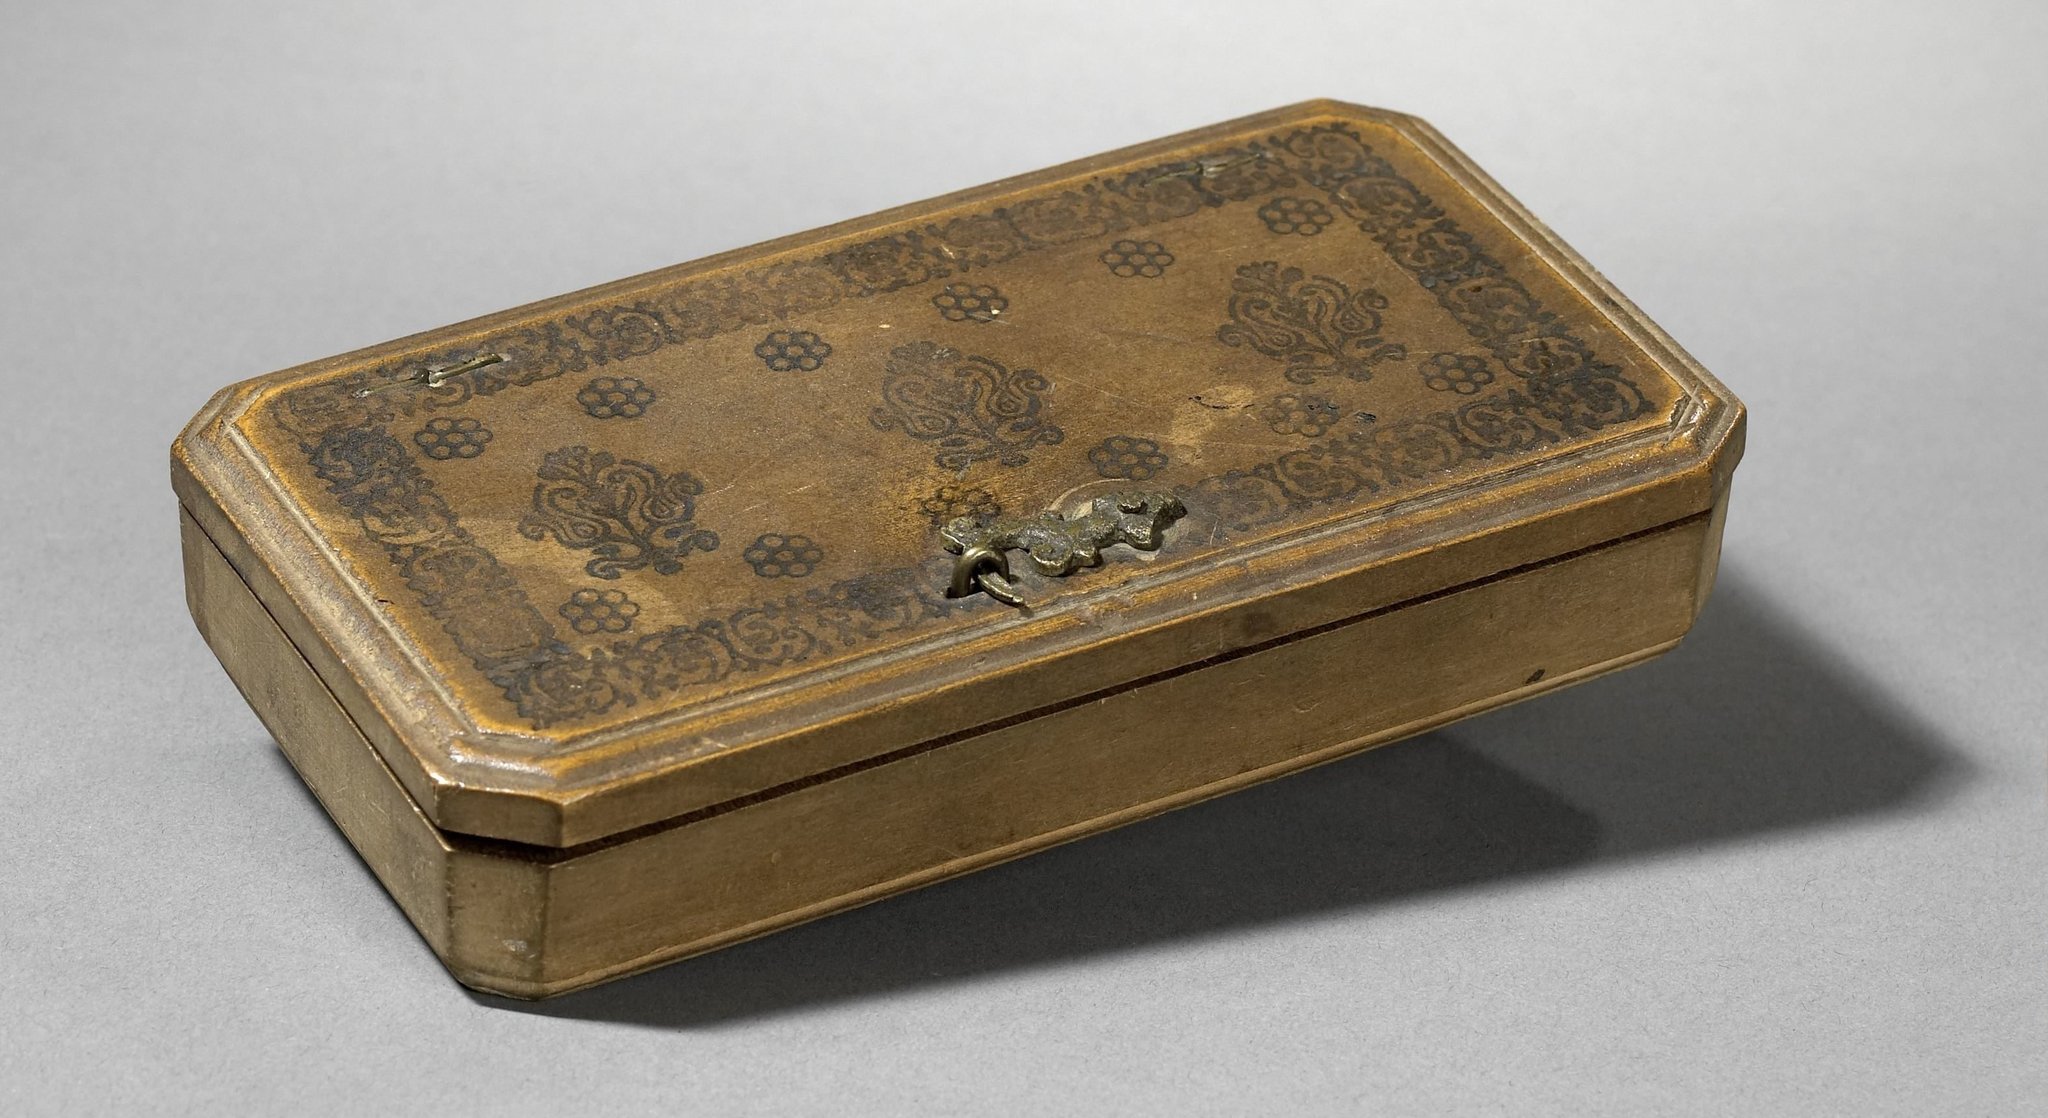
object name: box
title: Muntgewichtdoos met 12 muntgewichten, 7 greingewichten en balans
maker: jacob l admiral (ii)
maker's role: print maker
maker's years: 1700-1770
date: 1755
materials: copper, iron, wood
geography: amsterdam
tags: amsterdam, print maker, jacob l' admiral (ii), netherlands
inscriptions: factory mark: ‘JACOB L'ADMIRAL JUNIOR / EYK-MEESTER GENERAL / over de Geheel UNIE / Resudeerende / te Amsterdam’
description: 12 messing muntgewichten (allemaal gemerkt met gekroonde leeuw tussen I - L - A en een extra ingestempelde A in een van de hoeken) met ijzeren balans met koperen schalen en 7 remedie gewichtjes in houten doos, met etiket. 1 Guiny 8,25 g ½ Guiny 4,11 g 1 Ryder 9,95 g ½ Ryder 4,99 g 1 Ducaat 6,99 g ½ Ducaat 4,48 g 1 Ducaton 11,03 g ½ Ducaton 5,51 g 2 Pistool 13,46 g 1 Pistool 6,70 g ½ Pistool 3,34 g 4 Pistool 26,91 g